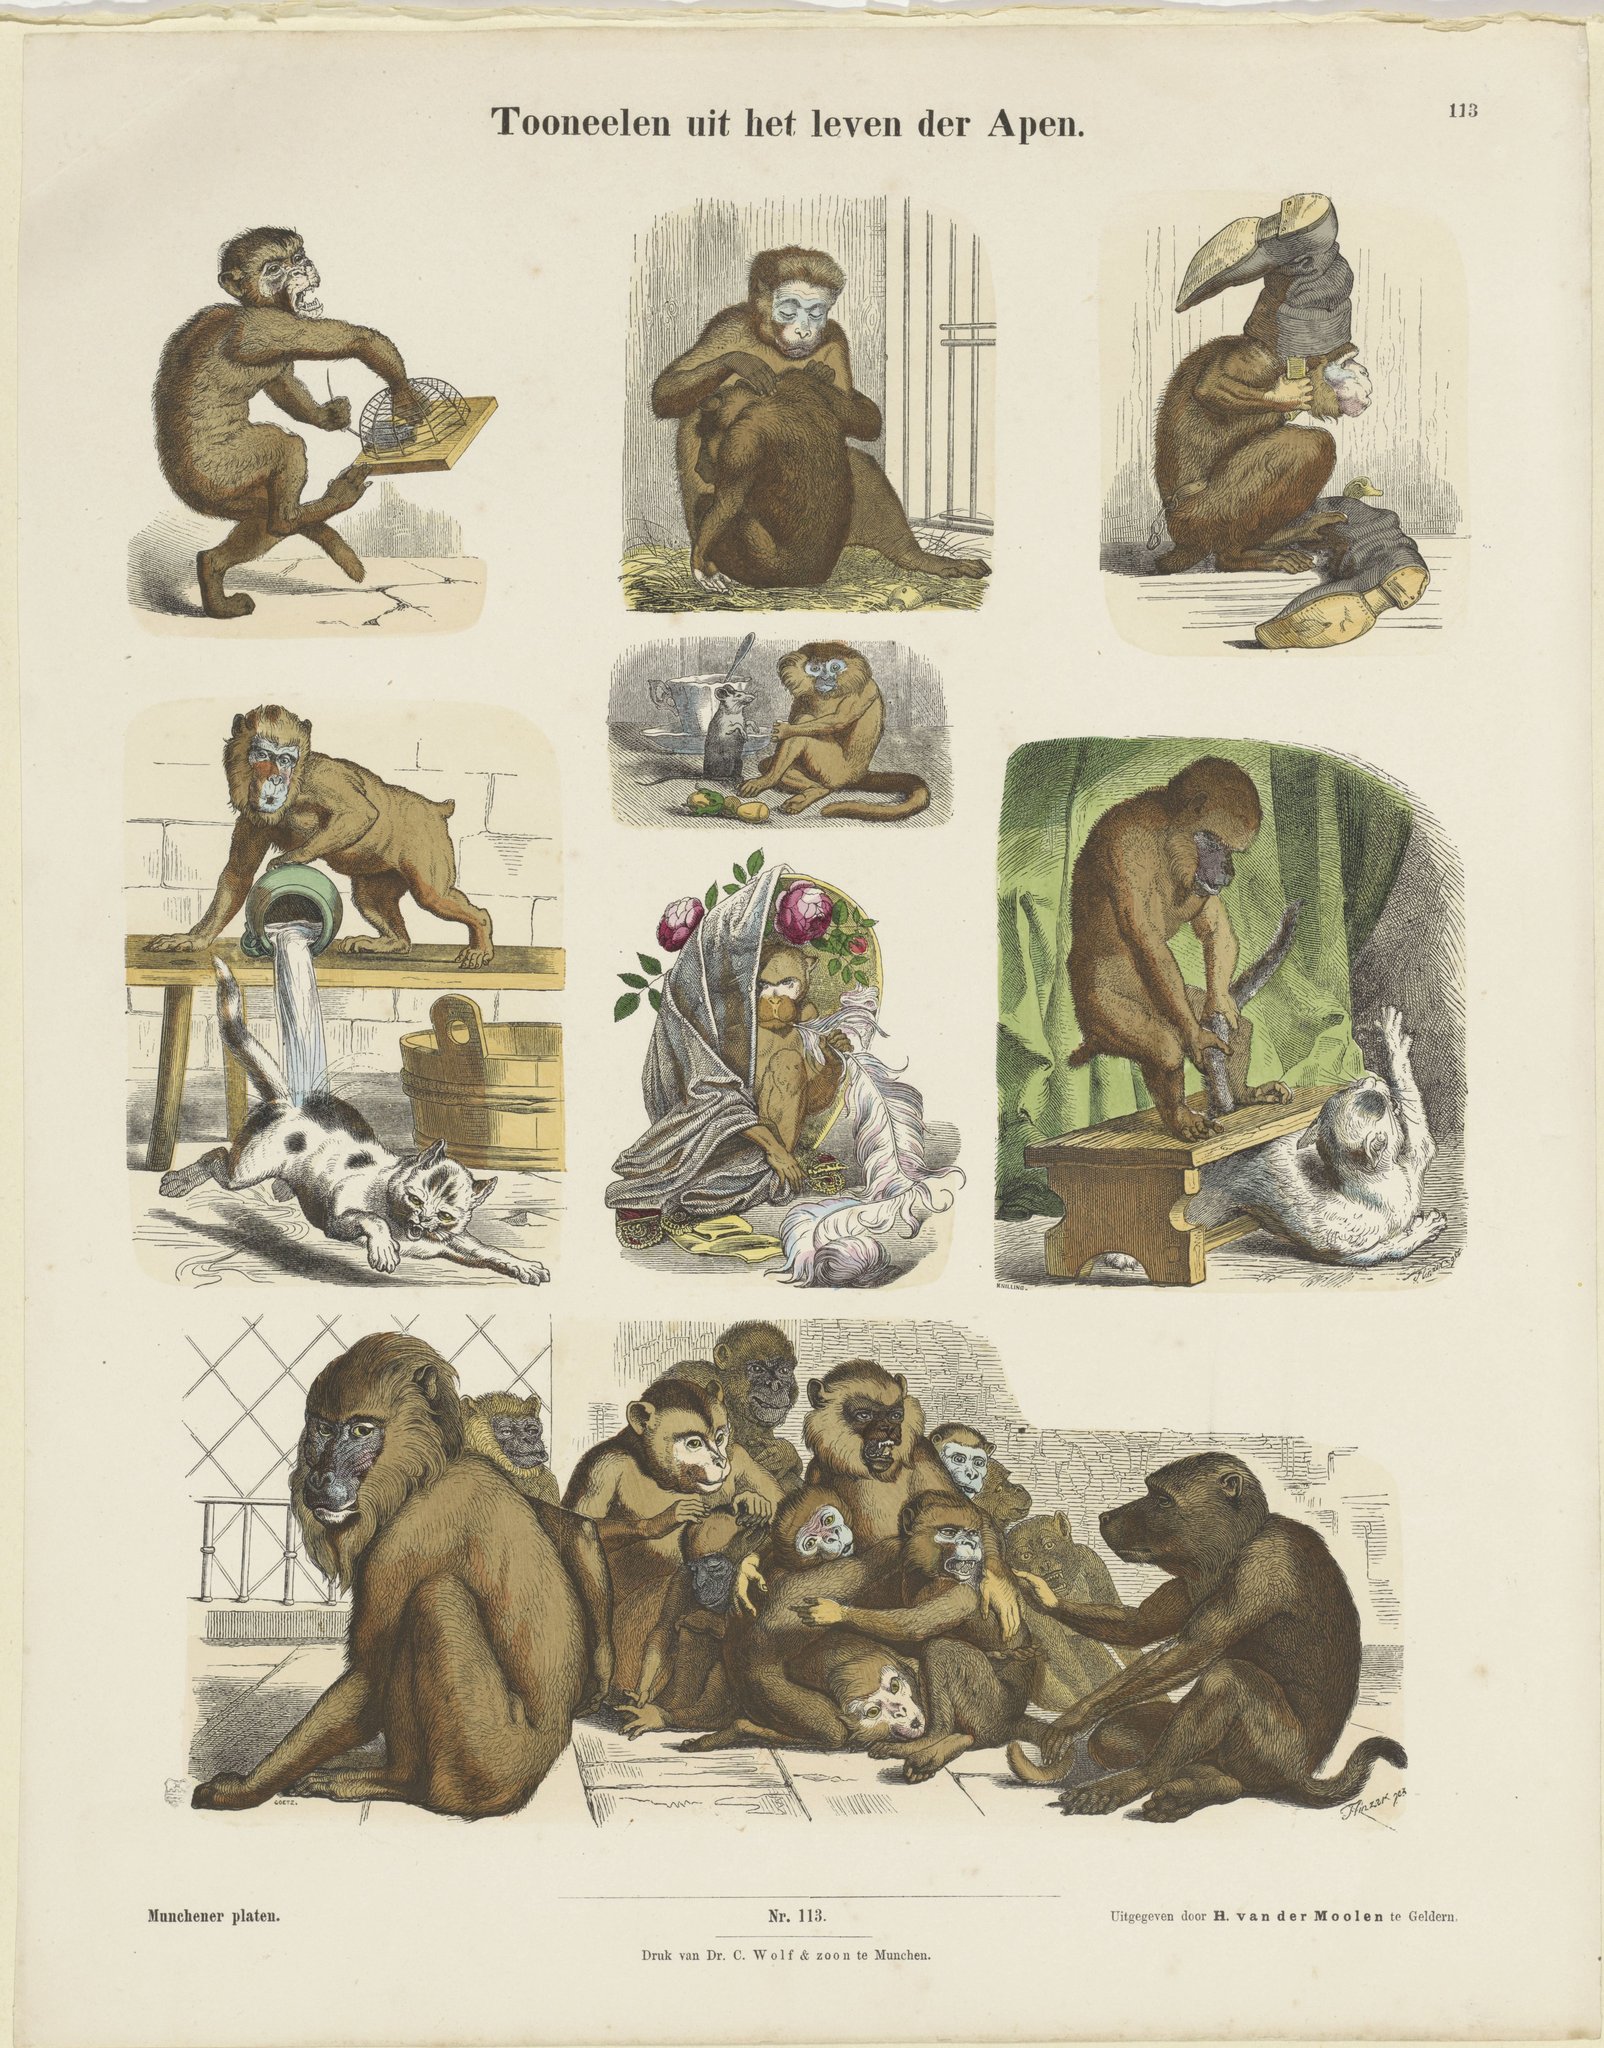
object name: print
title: Tooneelen uit het leven der apen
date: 1843-1920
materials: paper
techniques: colour, letterpress printing, engraving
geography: germany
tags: monkeys, apes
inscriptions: collector's mark: Lugt 2760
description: Nederlandse editie van een prent uit de reeks "Munchener platen" uitgegeven door K. Braun & Fr. Schneider te München met het adres van wederverkoper Hermann van der Moolen.